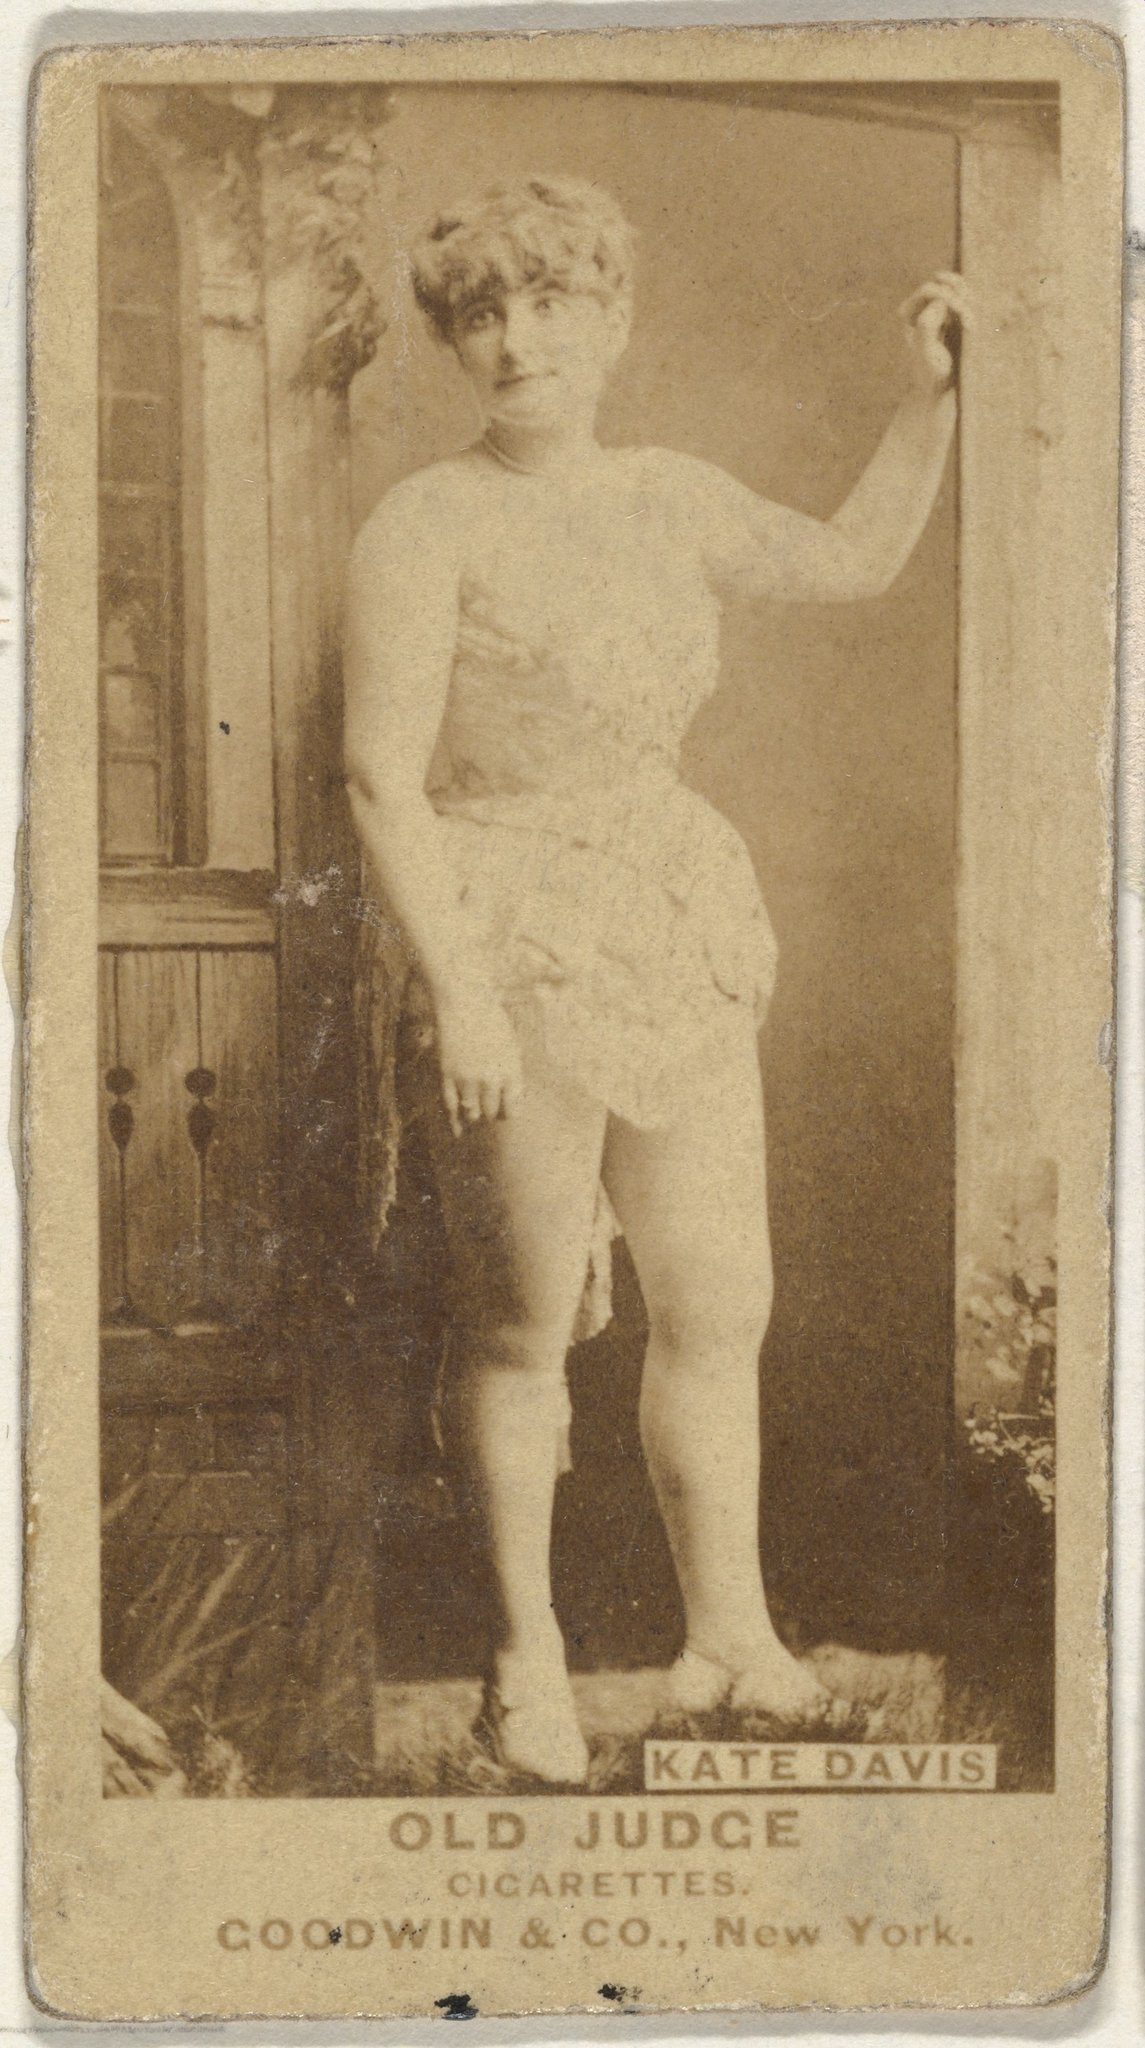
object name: photograph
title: Kate Davis, from the Actors and Actresses series (N171) for Old Judge Cigarettes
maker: goodwin & company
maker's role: publisher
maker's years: 1850-1950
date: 1886-1890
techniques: albumen silver print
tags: portraits,women,actresses